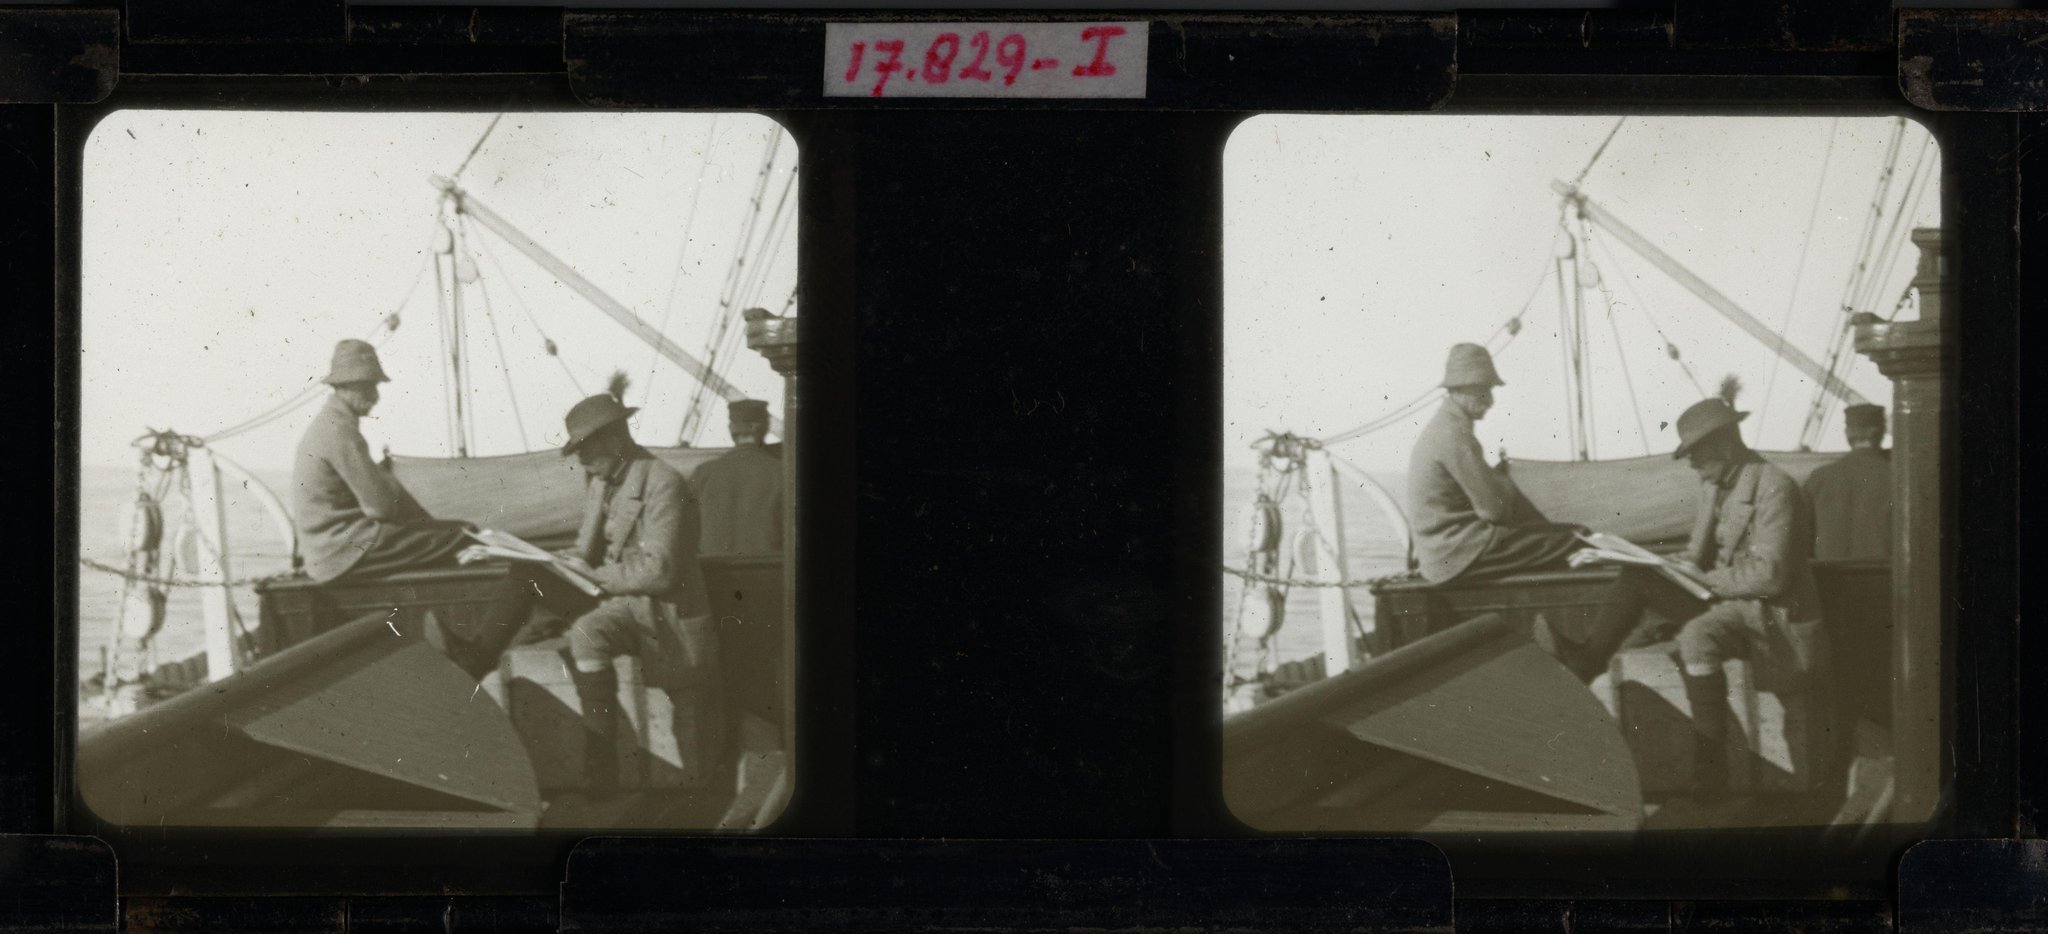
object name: album leaf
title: Mannen zittend op het dek van een schip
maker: Anonymous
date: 1893-1923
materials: glass, metal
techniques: slide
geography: paris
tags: crew ~ ship